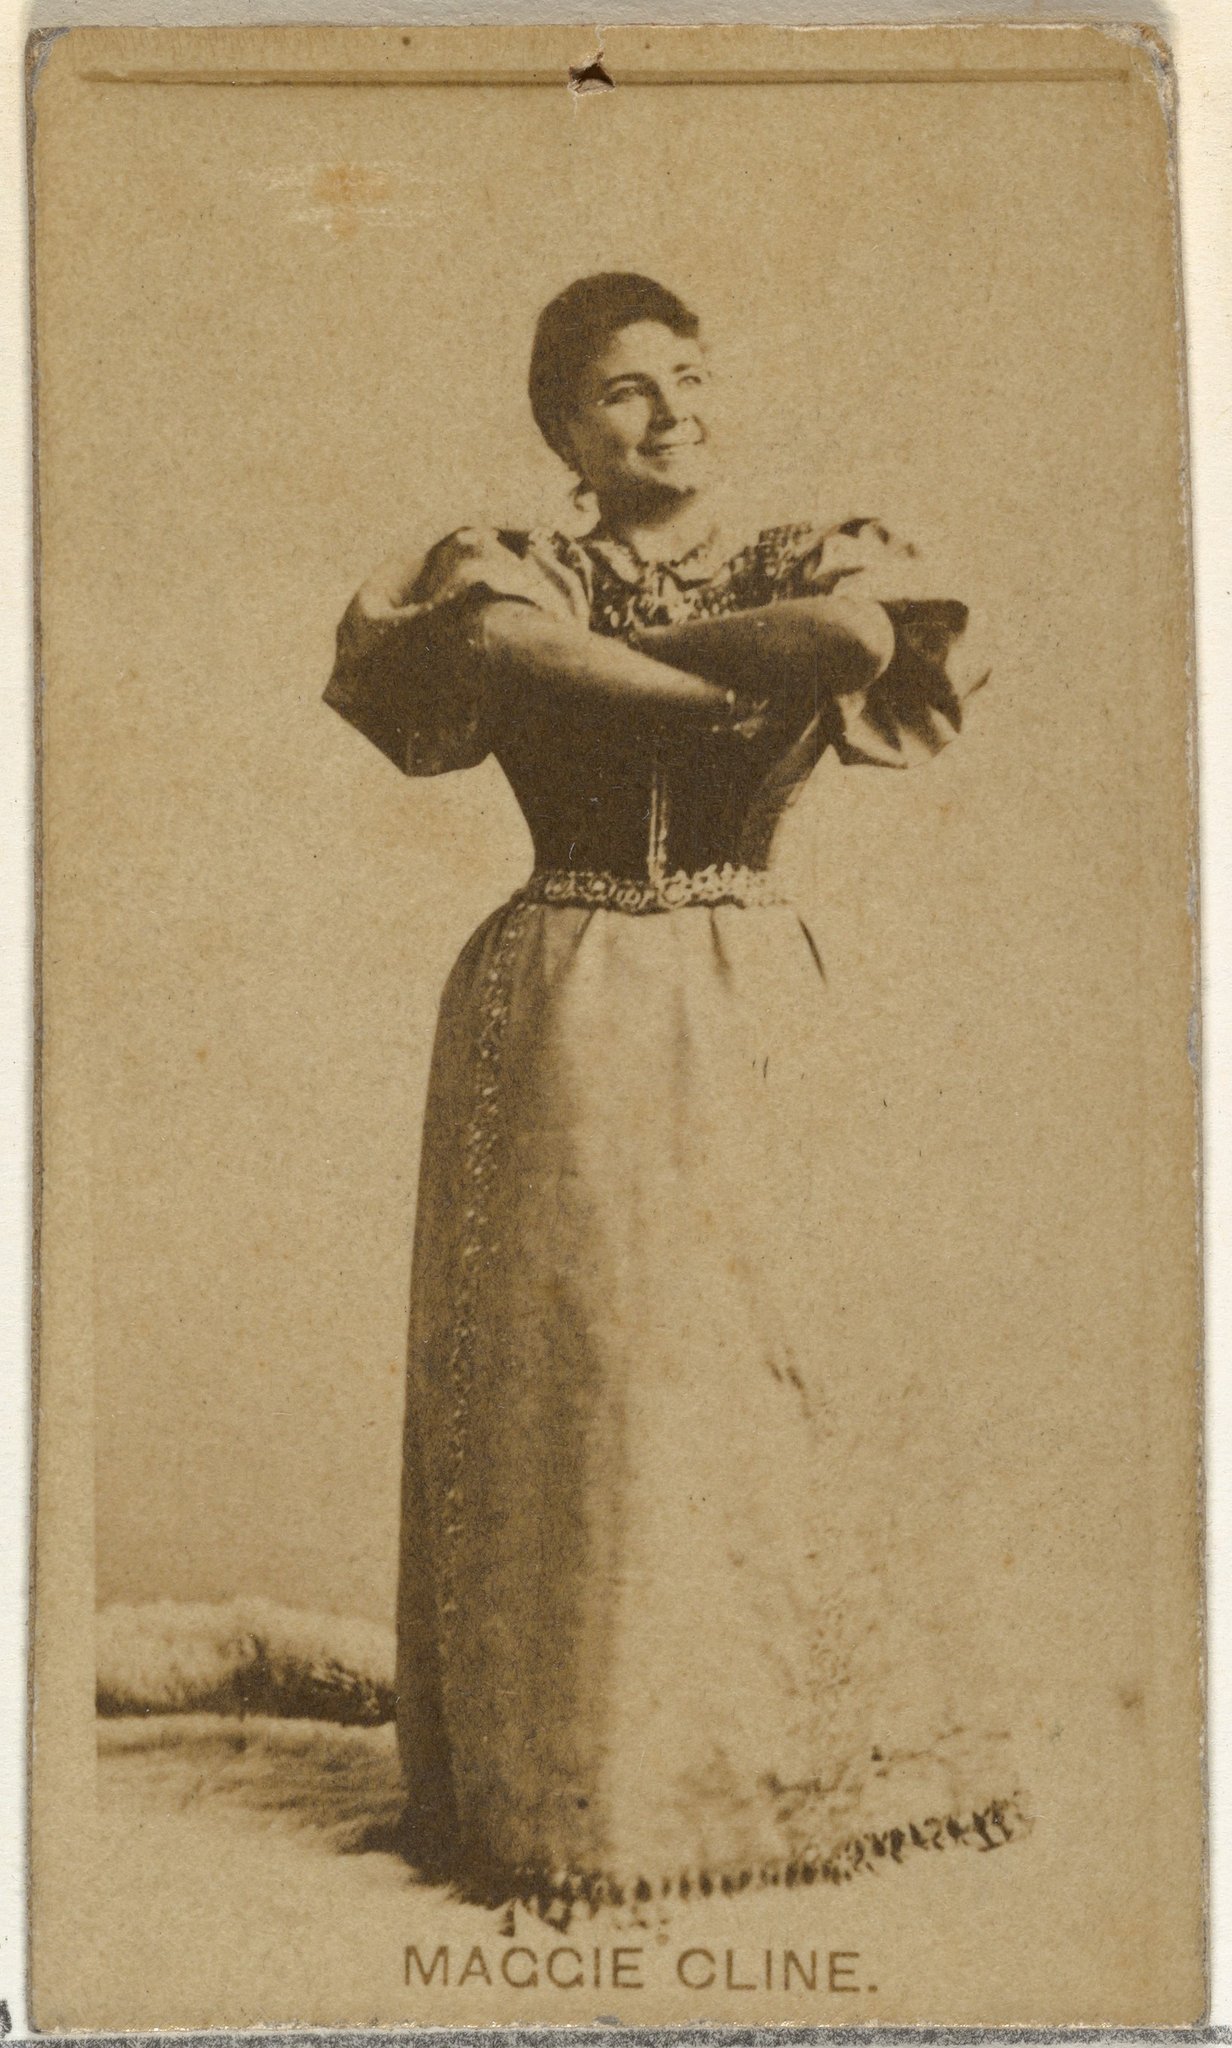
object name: photograph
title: Maggie Cline, from the Actors and Actresses series (N145-8) issued by Duke Sons & Co. to promote Duke Cigarettes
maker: w. duke, sons & co.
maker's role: publisher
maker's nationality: american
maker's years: 1870-1920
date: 1891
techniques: albumen silver print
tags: portraits,women,actresses